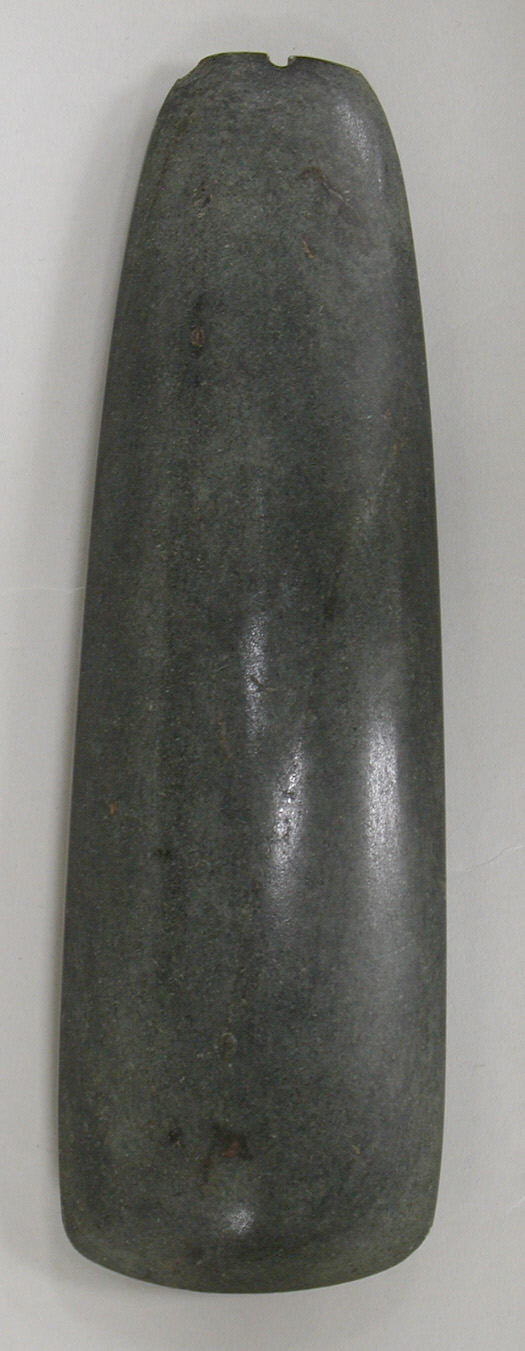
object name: celt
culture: mexican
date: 1501-1600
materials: stone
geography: mexico